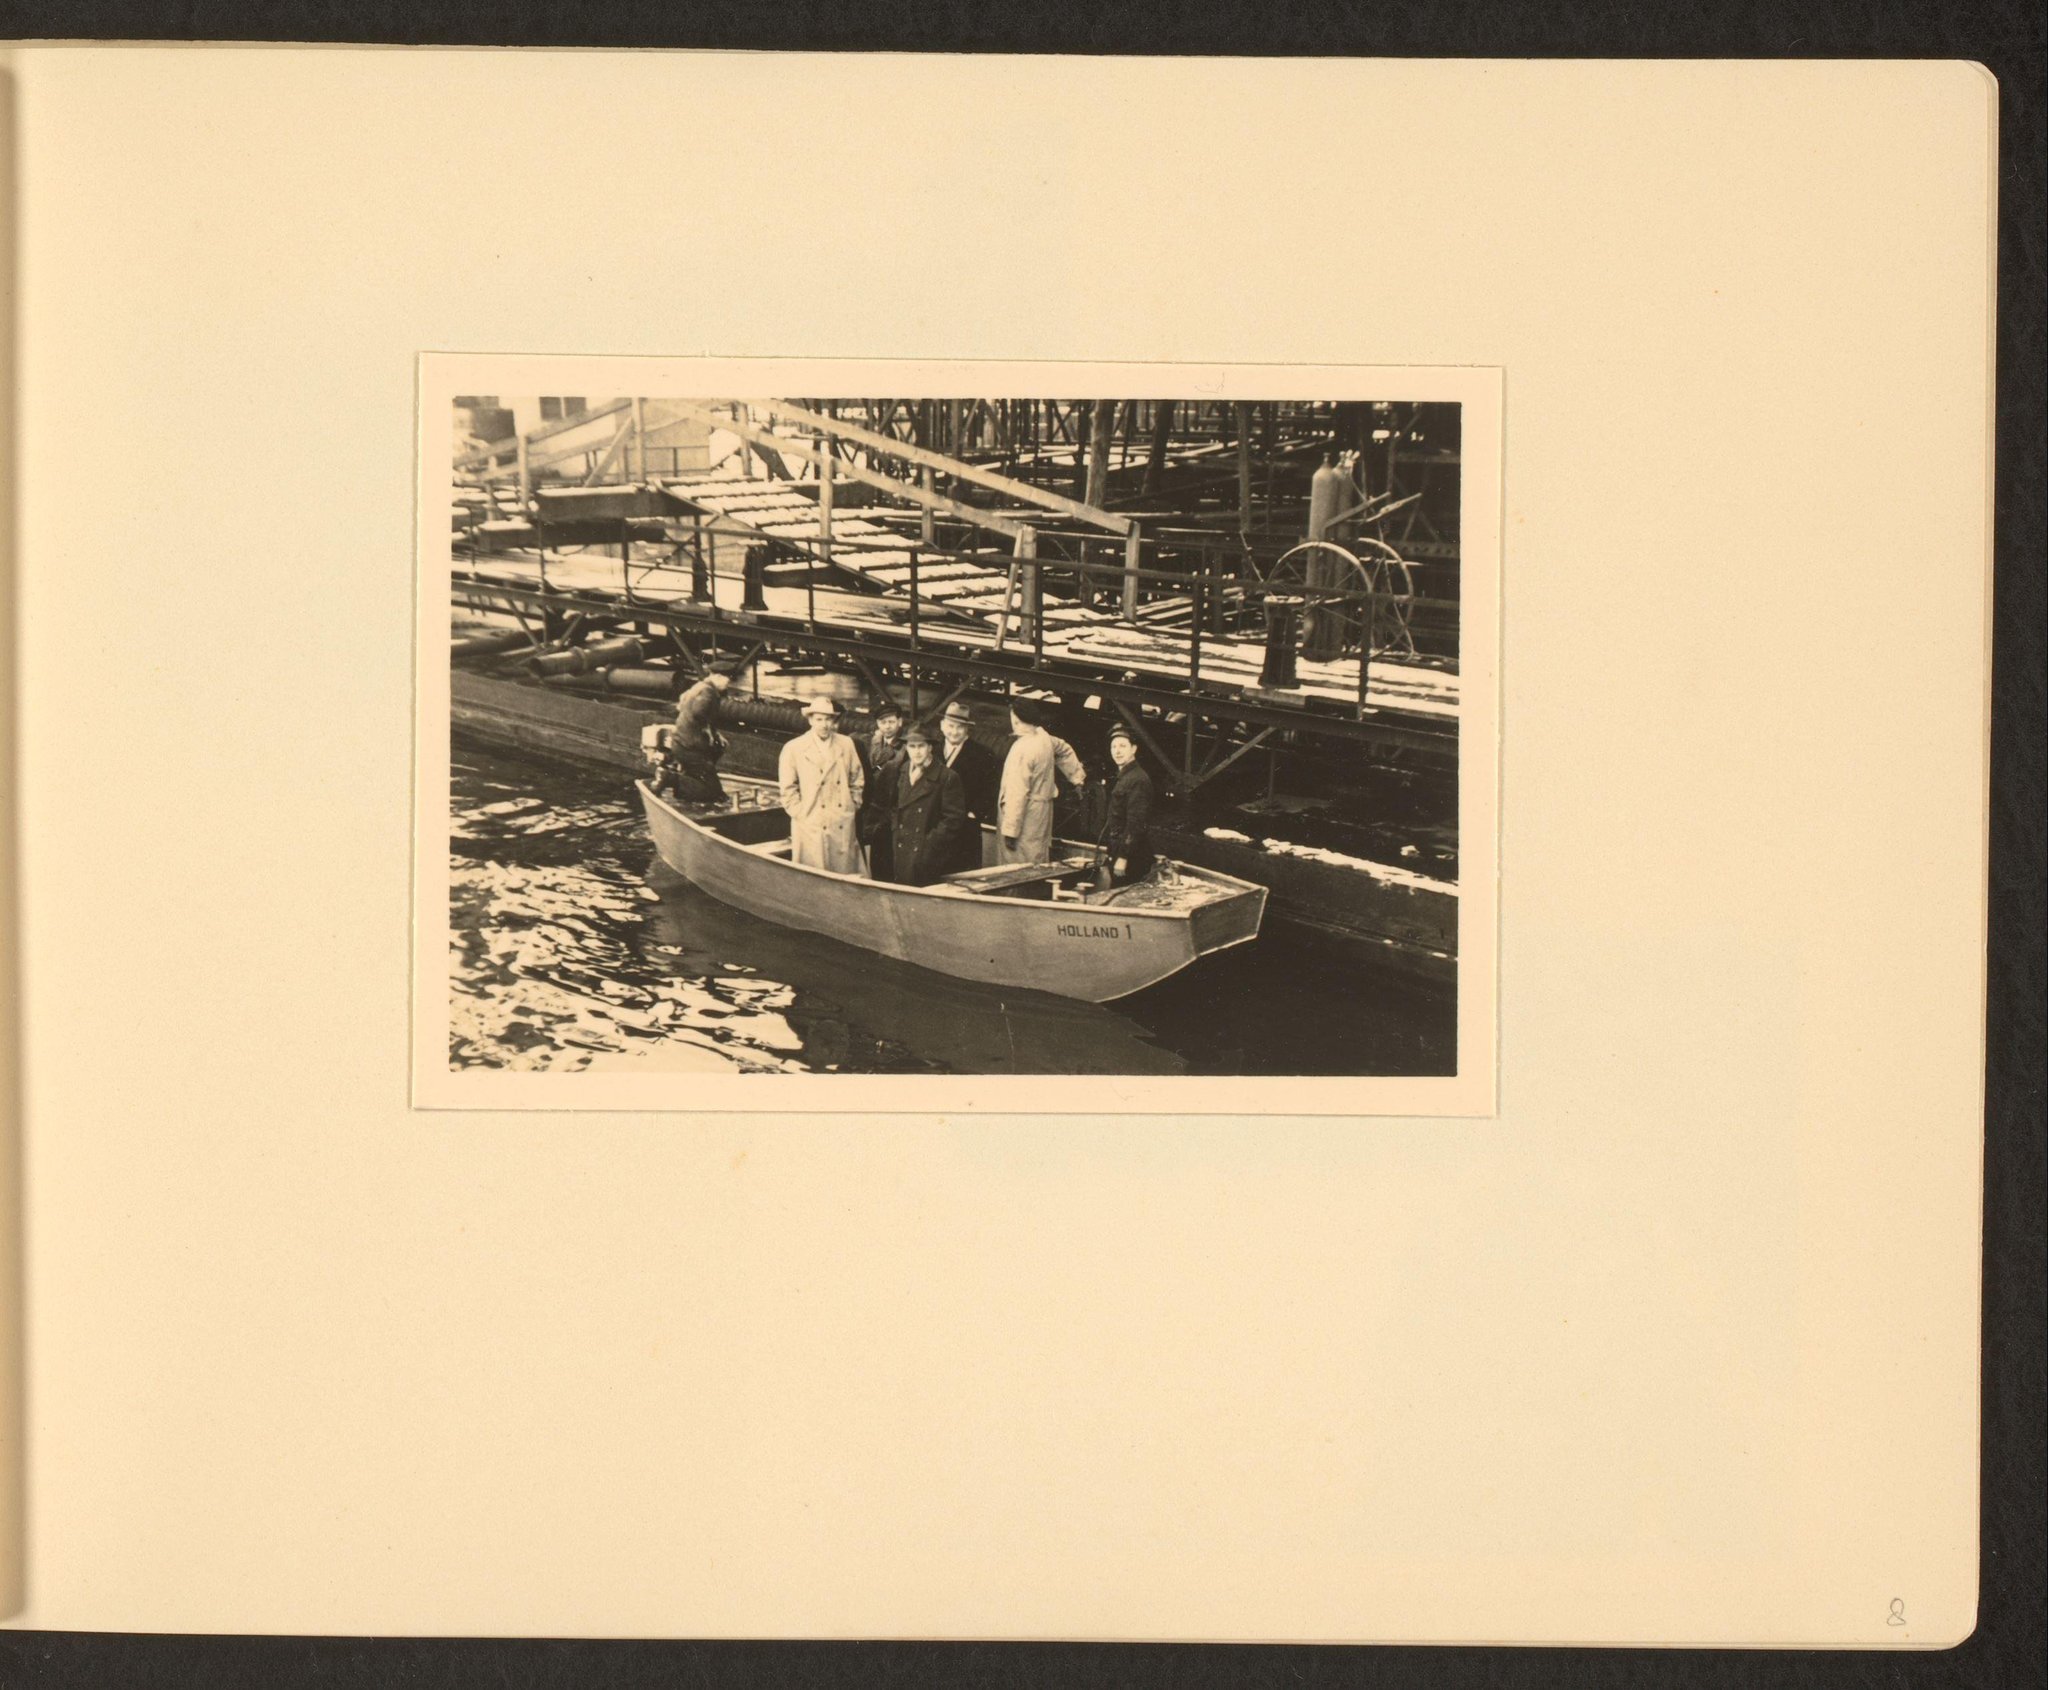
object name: photograph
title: Holland 1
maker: Anonymous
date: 1902-1953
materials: paper, photographic support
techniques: gelatin silver print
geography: emden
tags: building a ship, ship under construction, pier, quay, wharf, steamship, motorship, north sea flood of 1953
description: Albumblad met een foto waarin een groep mannen poseert in de metalen sloep Holland 1, gebouwd door Nordseewerke Emden. Onderdeel van het fotoalbum 'Emden hilft Holland'.